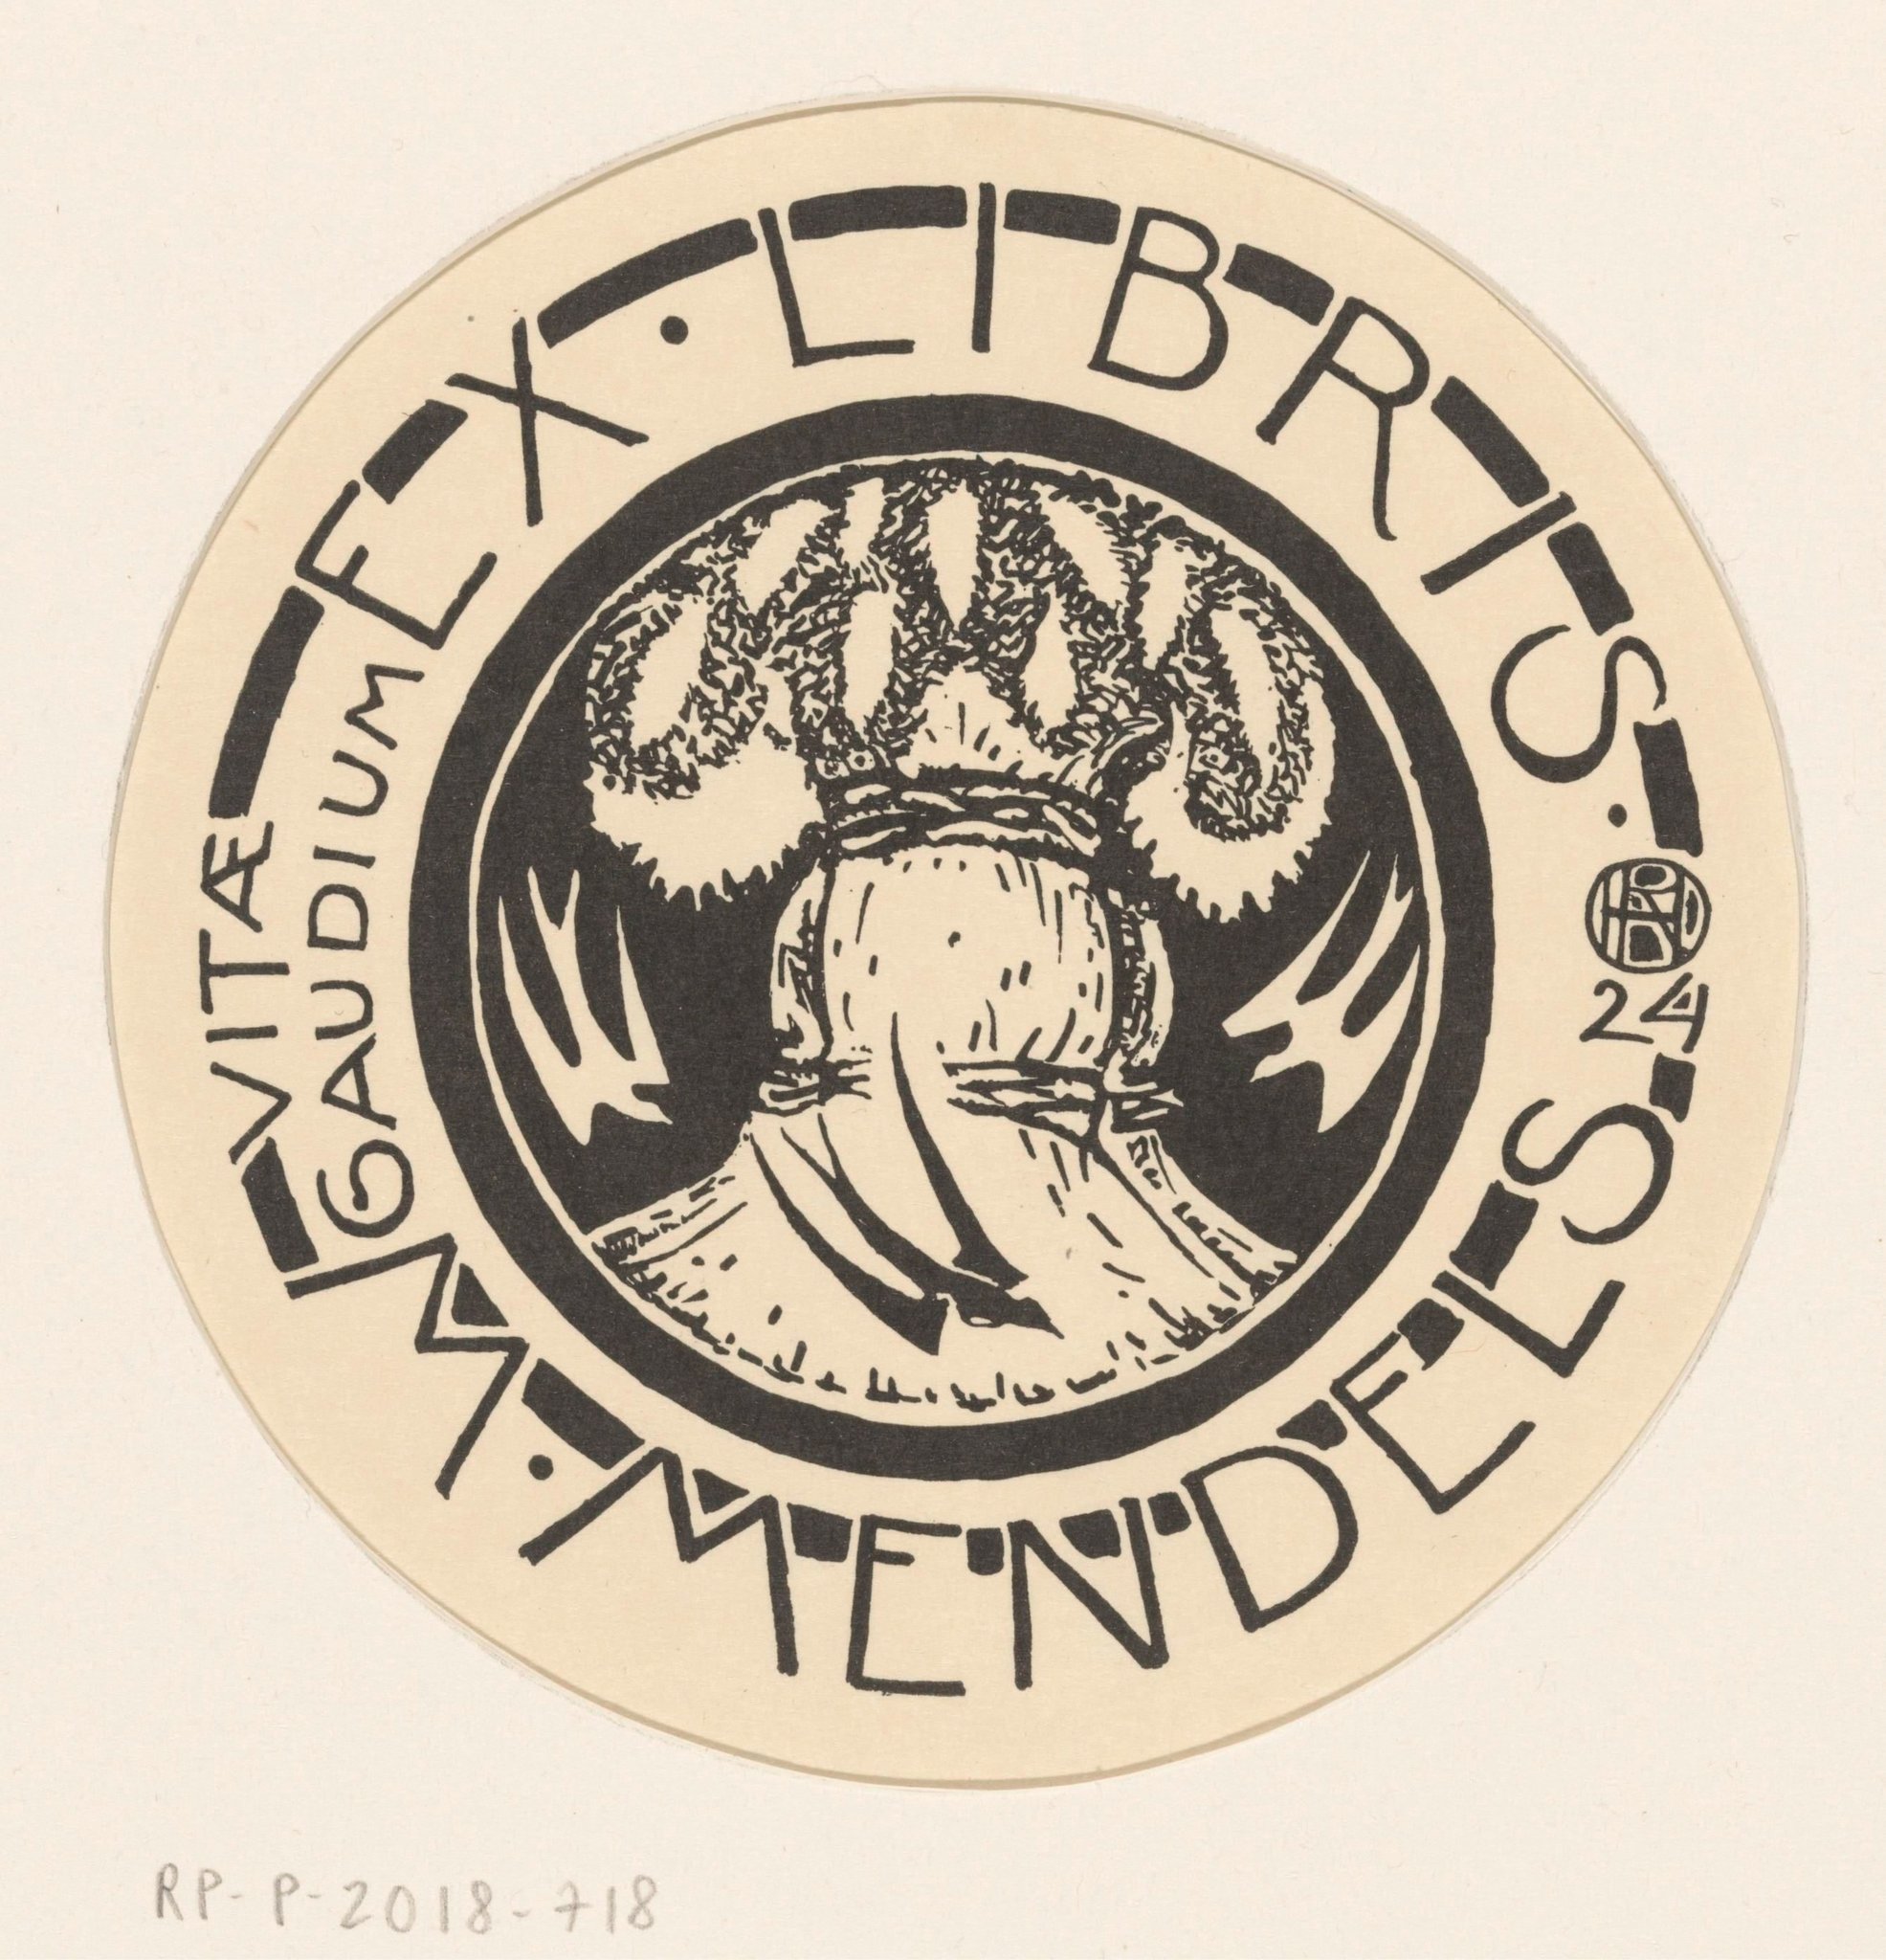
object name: print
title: Vitae Gaudium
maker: richard nicolaüs roland holst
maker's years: 1868-1938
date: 1924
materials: paper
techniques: line block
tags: the hague, politician, song-birds: swallow, sheaf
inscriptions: number: ‘42’